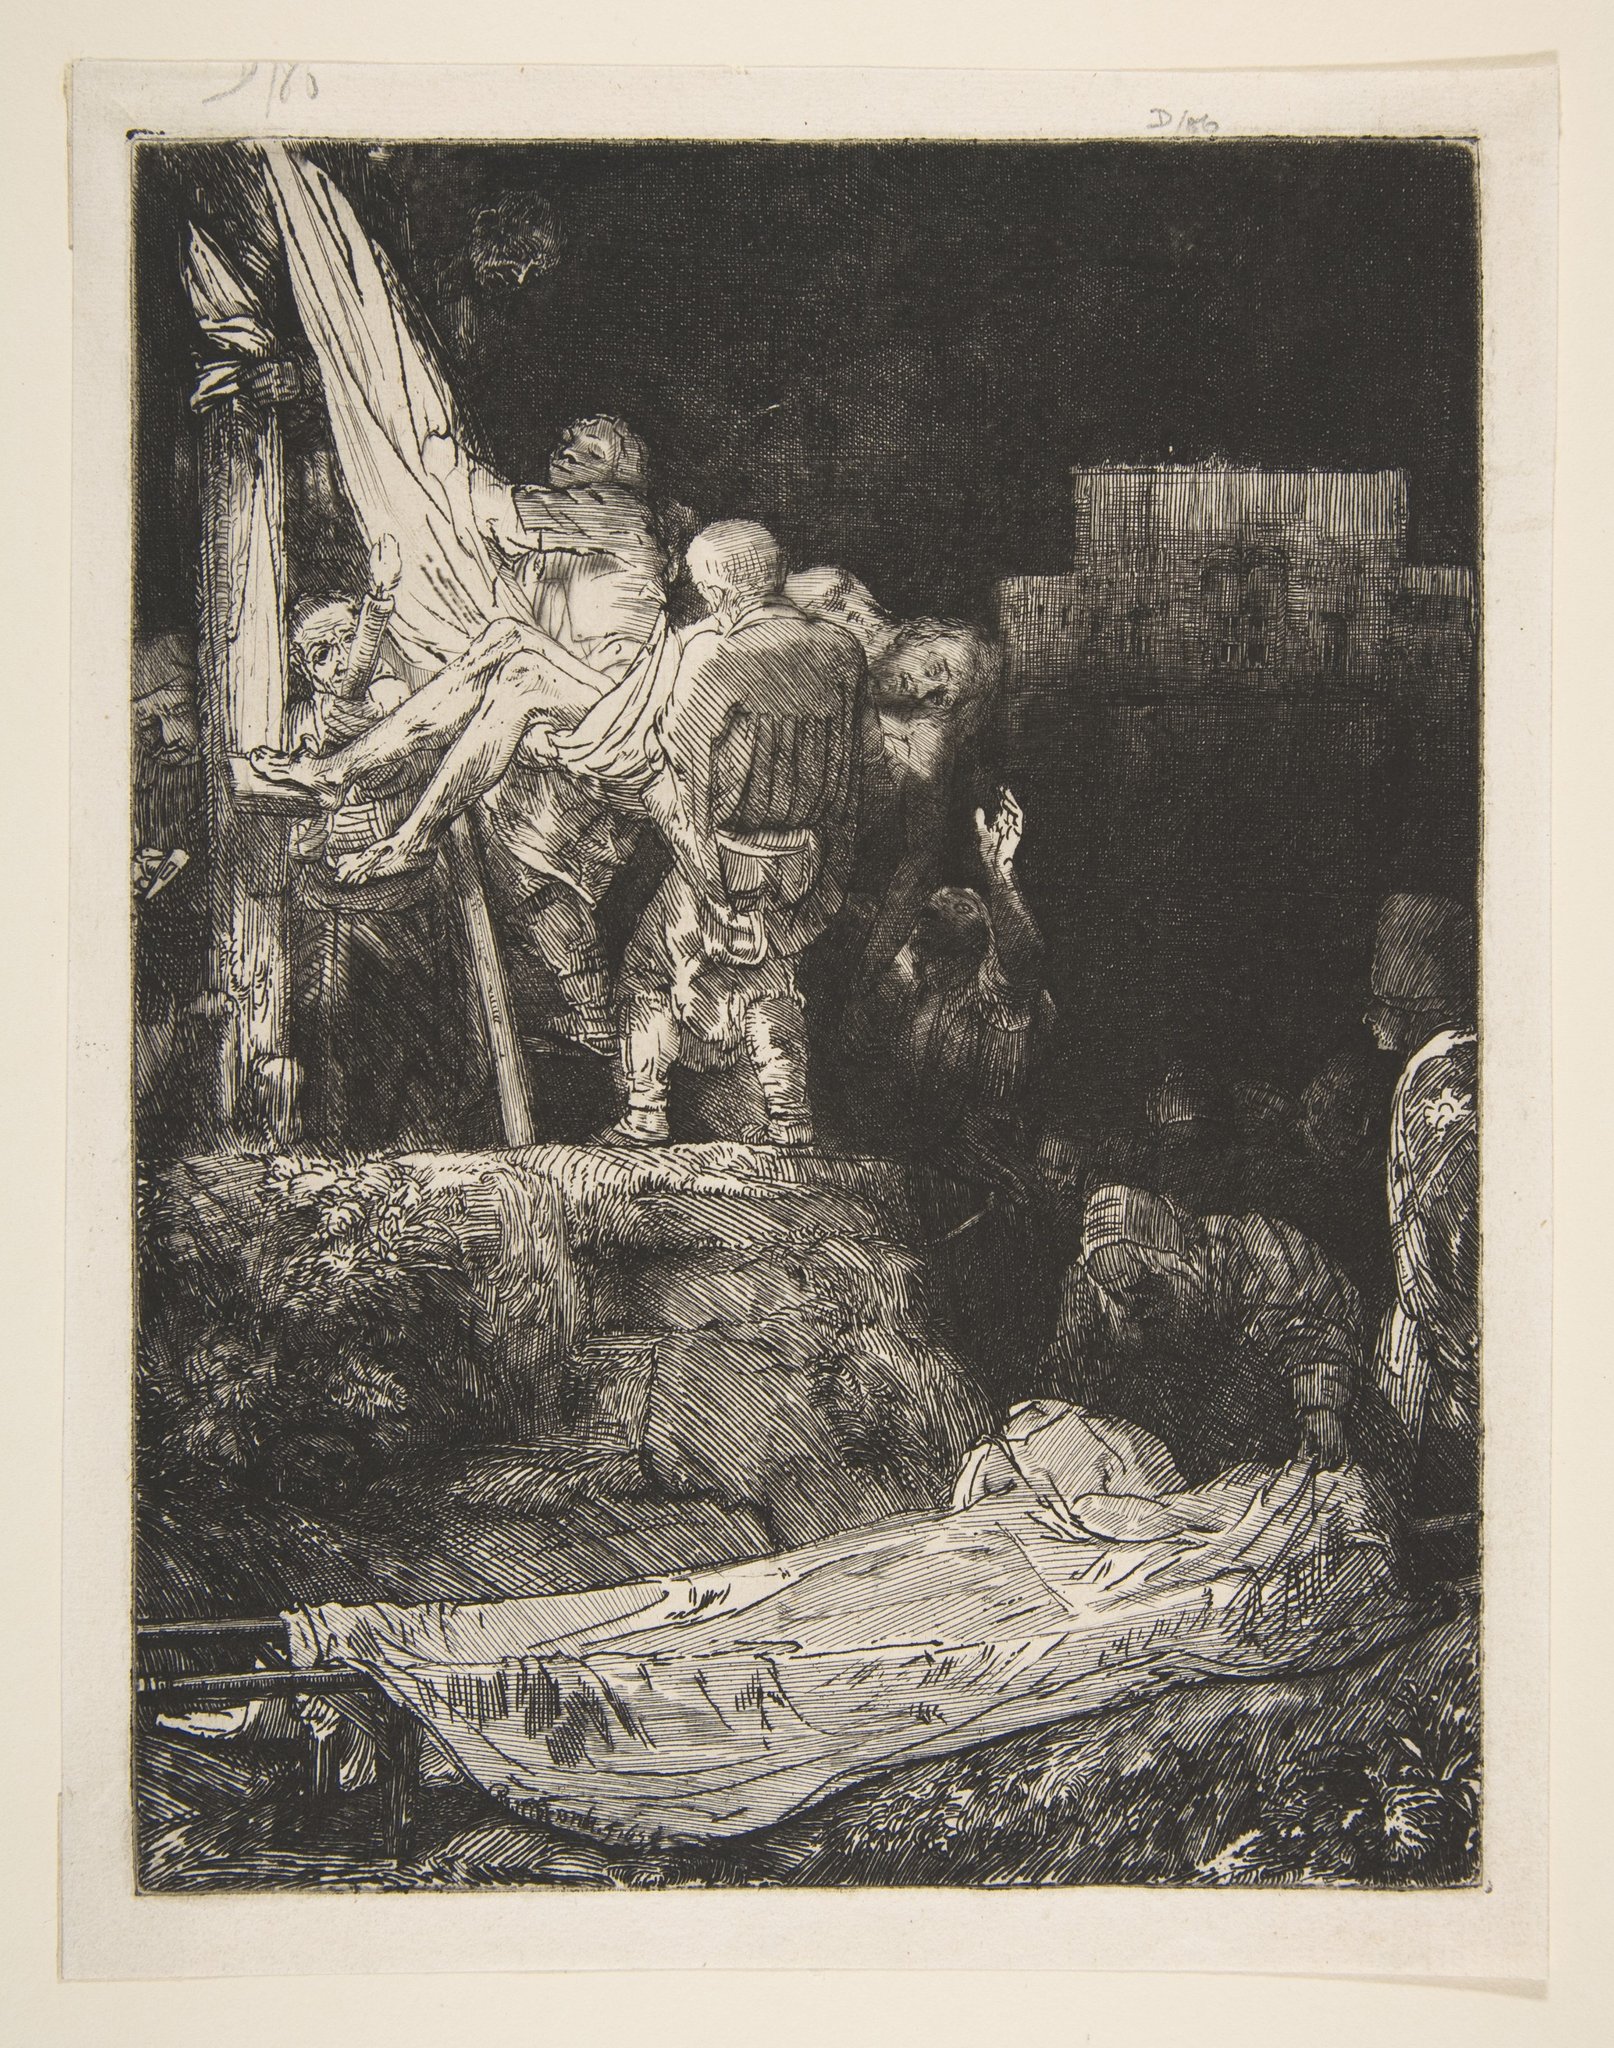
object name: print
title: Descent from the Cross by Torchlight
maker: rembrandt van rijn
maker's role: artist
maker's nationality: dutch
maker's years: 1606-1669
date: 1654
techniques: drypoint, etching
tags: descent from the cross